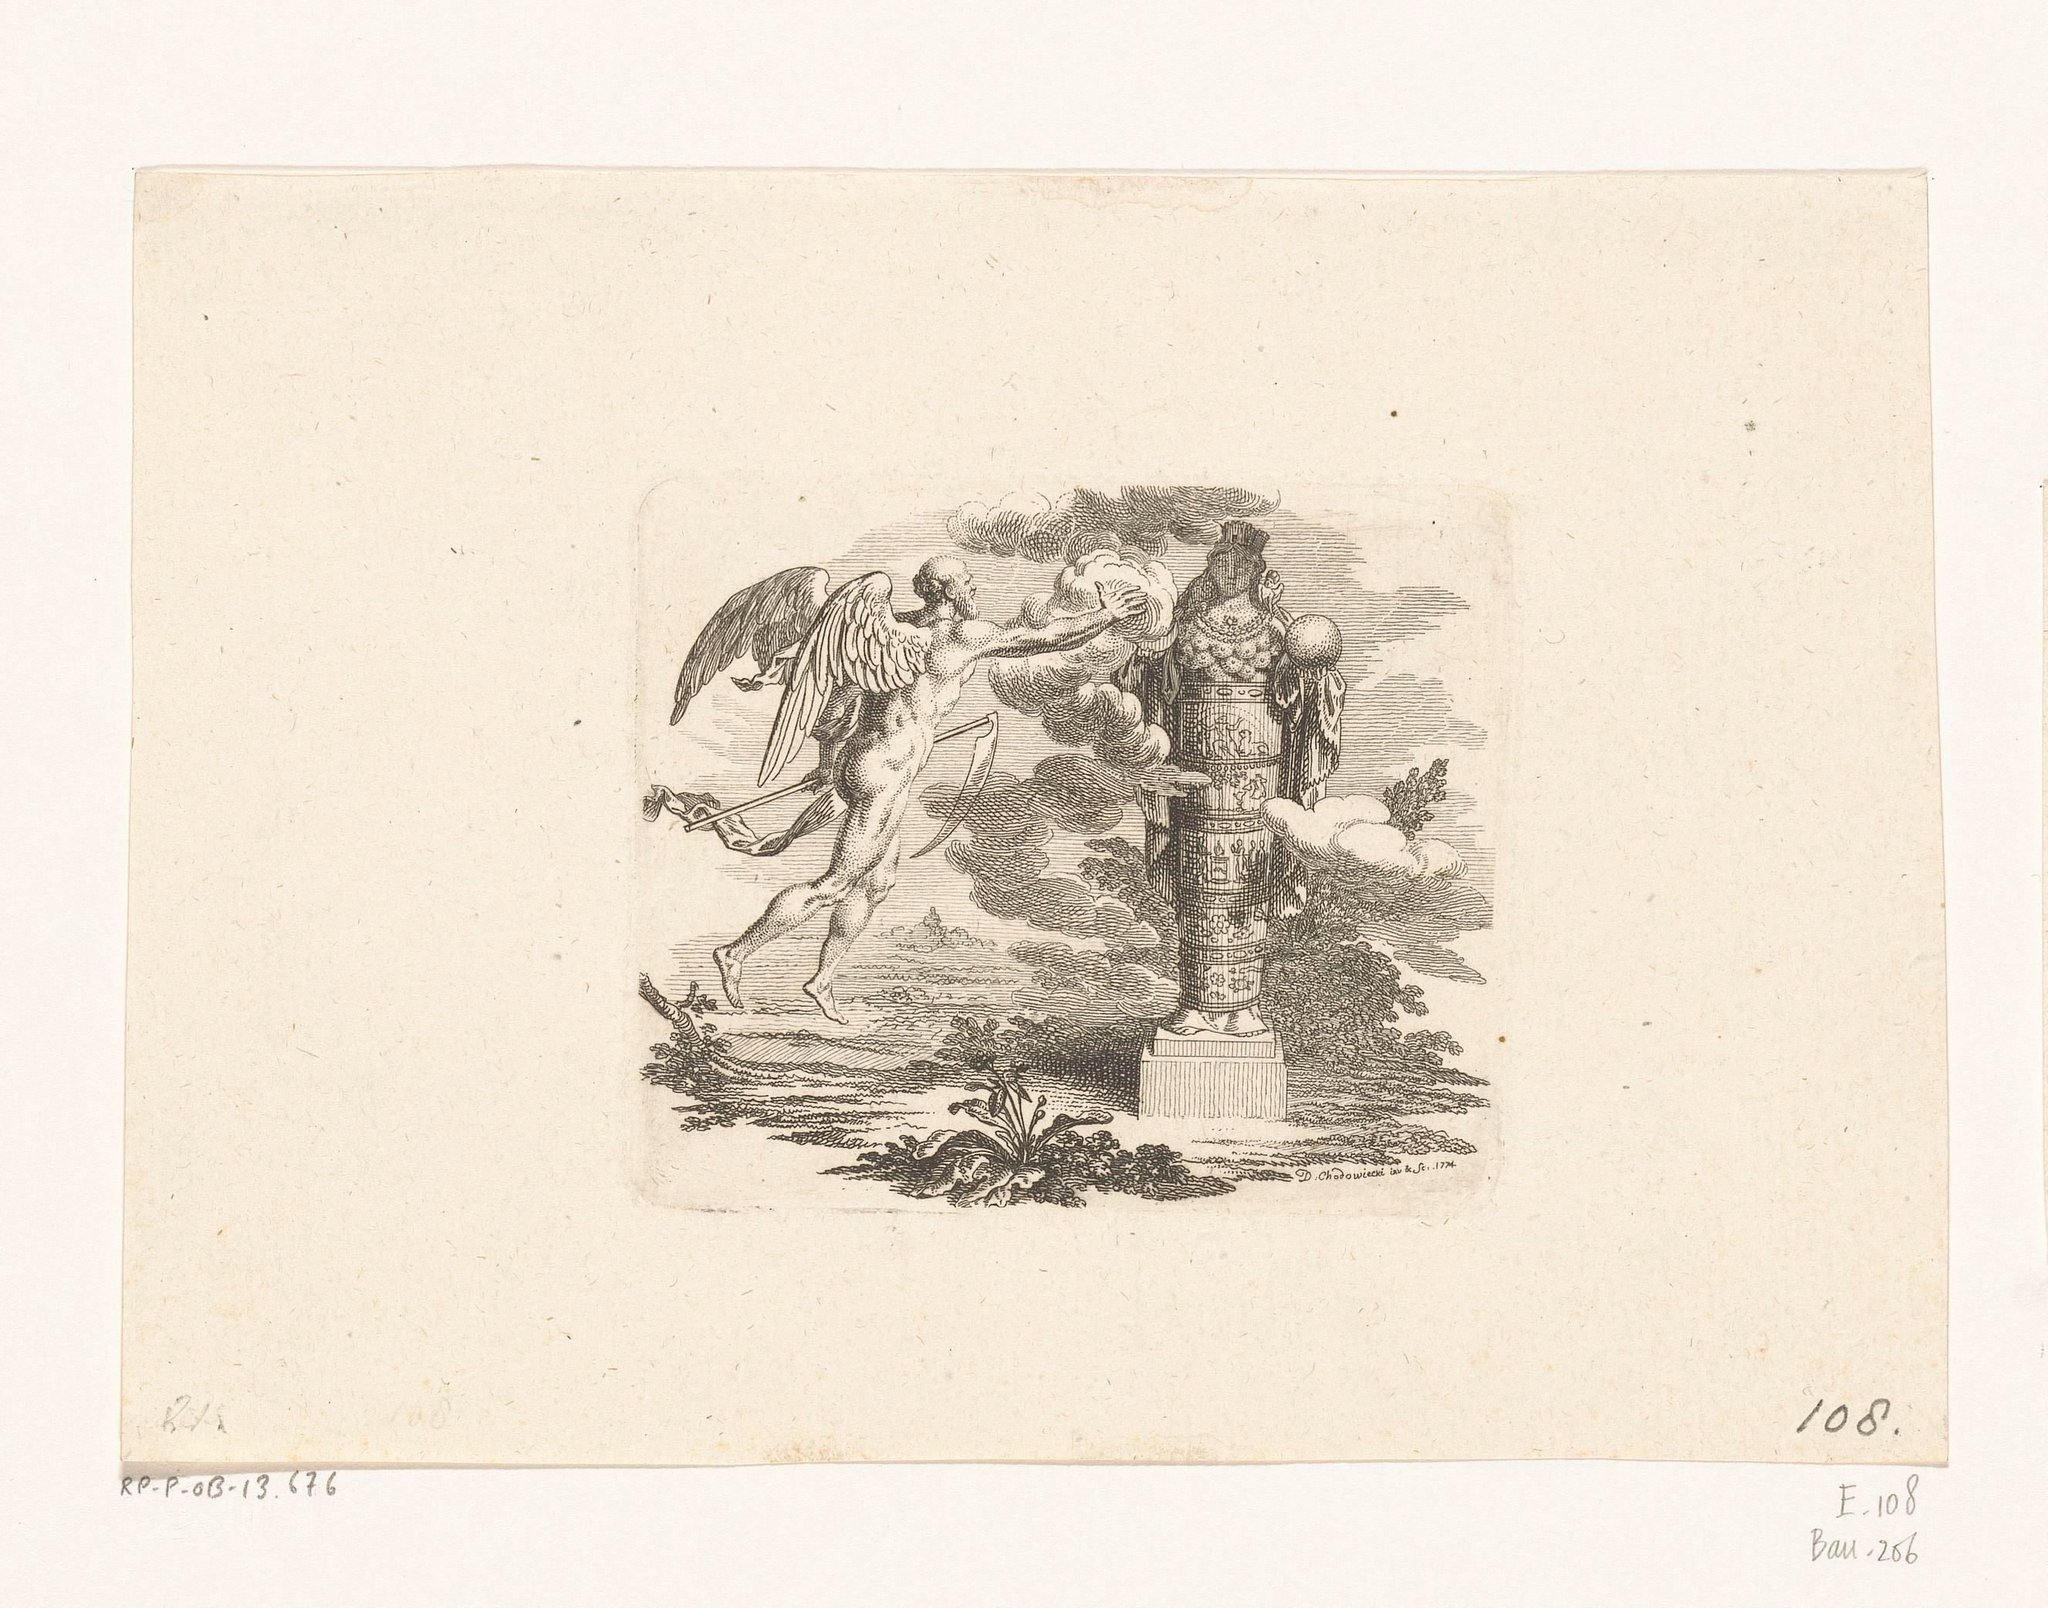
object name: print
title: Tijd onthult de Waarheid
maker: daniel nikolaus chodowiecki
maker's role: draughtsman, print maker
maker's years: 1726-1801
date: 1774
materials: paper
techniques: etching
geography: berlin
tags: 'natura' (allegorical figure or scene; or as diana of ephesus, with many breasts); 'natura' (ripa), time revealing truth; time carrying truth aloft, father time, man with wings and scythe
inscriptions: collector's mark: Lugt 2228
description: Tijd, een oude man met vleugels en een zeis, verjaagt de wolken voor een beeld van de natuur, voorgesteld als Diana van Efeze met in haar linkerhand een wereldbol.